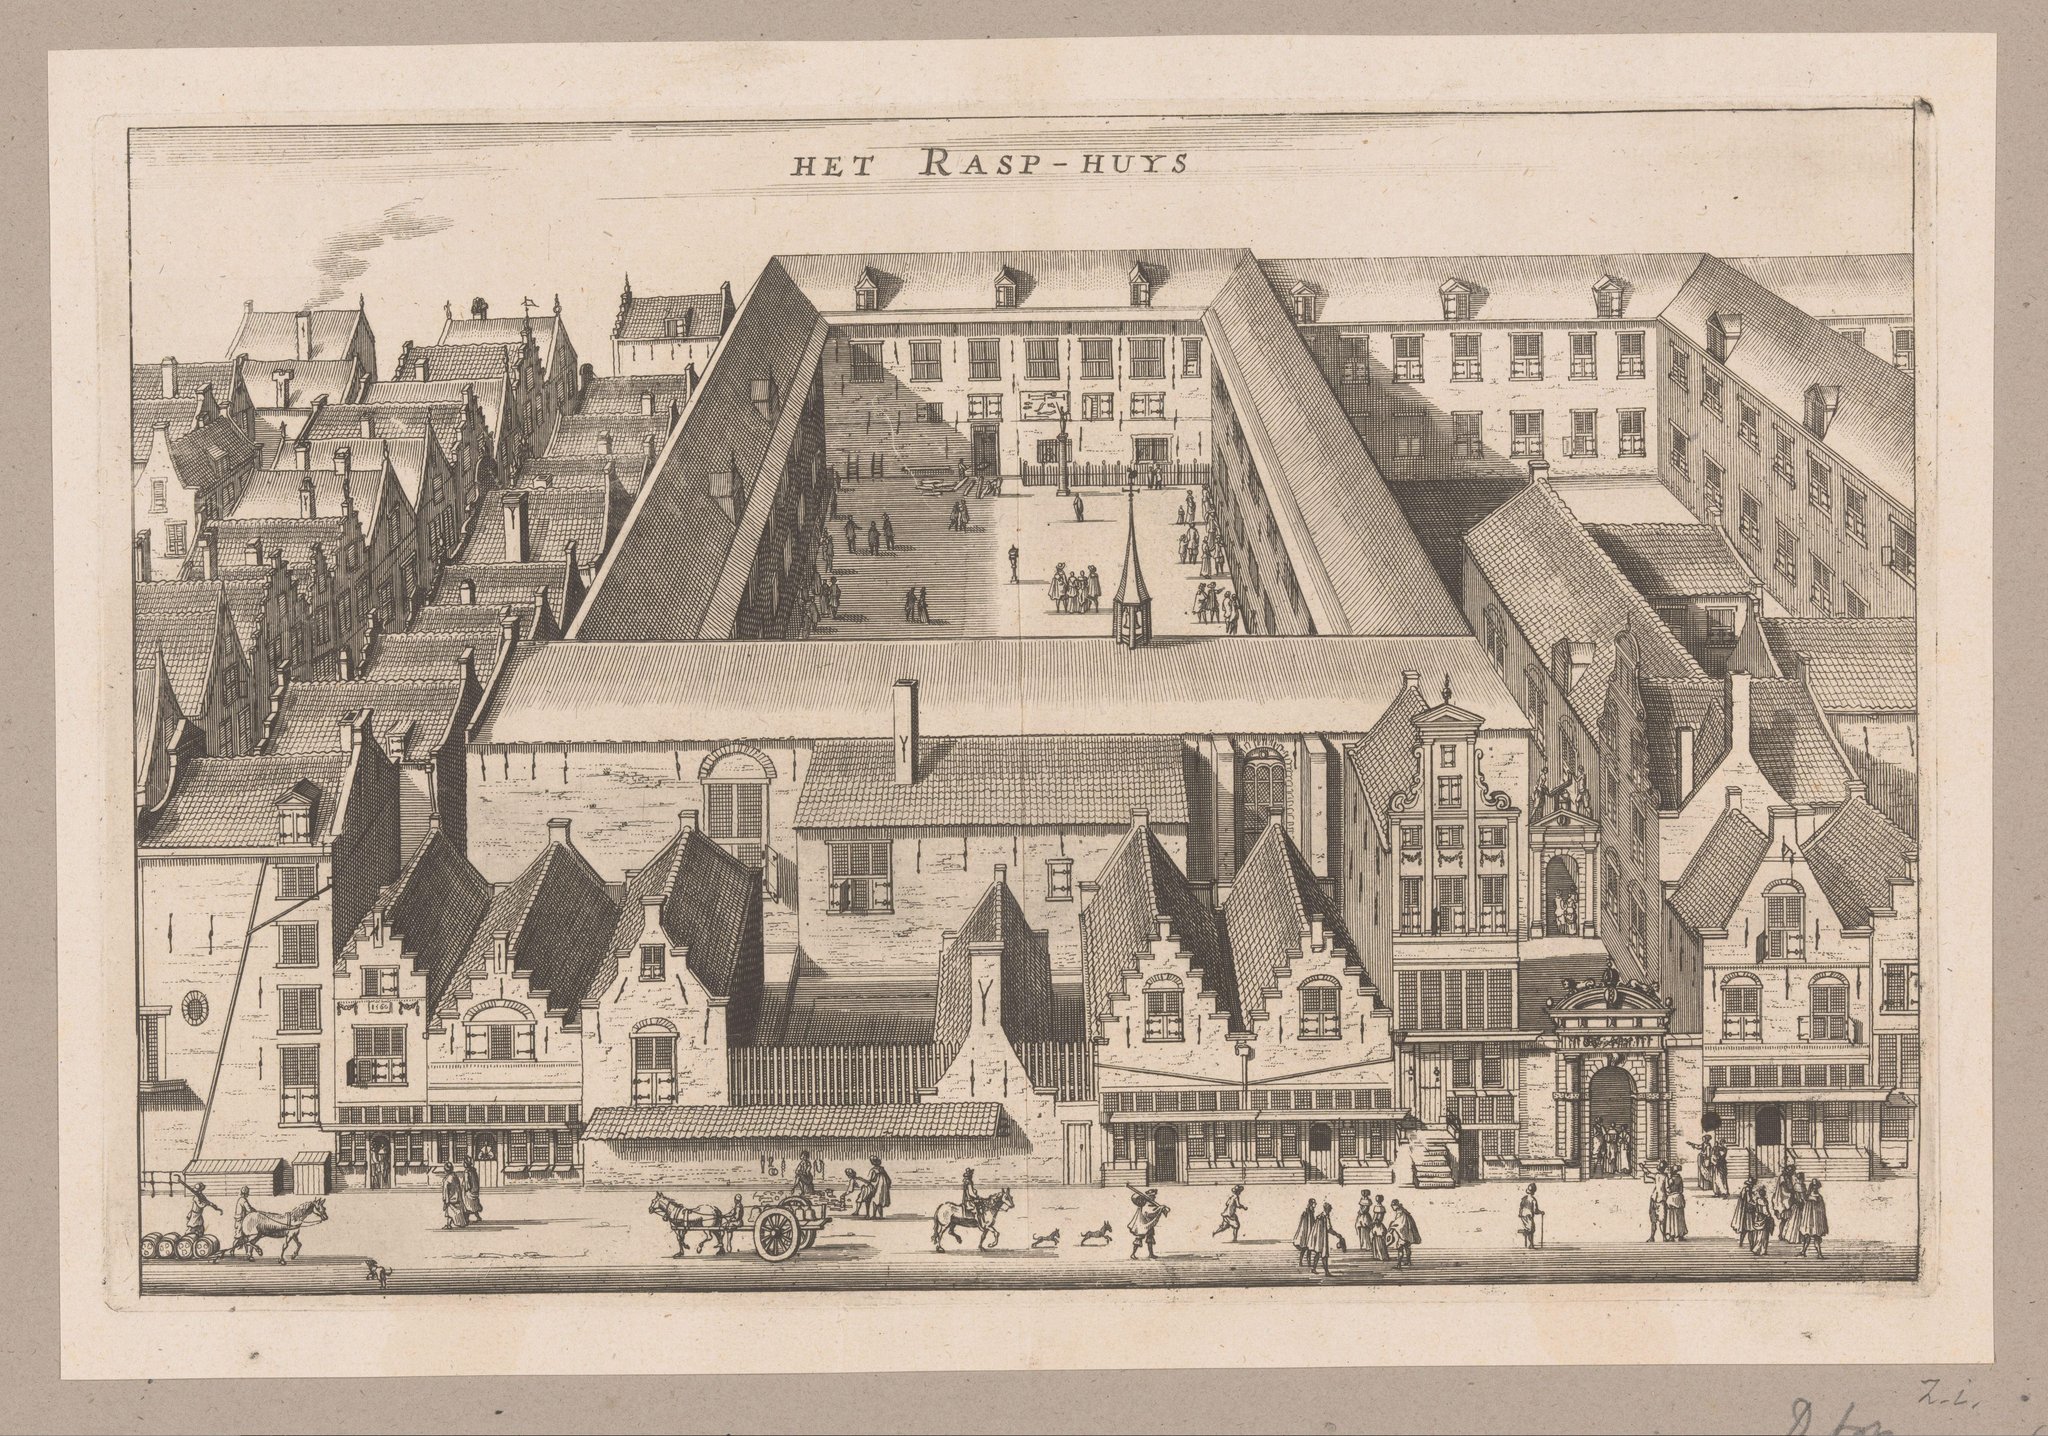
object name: print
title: Het Rasp-Huys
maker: jacob van meurs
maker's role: draughtsman, print maker, publisher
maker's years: 1619-1680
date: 1663-1664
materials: paper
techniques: etching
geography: amsterdam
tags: prison, jail, gate, entrance, courtyard, workhouse, penal camp, penitentiary, chain gang, street (+ city(-scape) with figures, staffage)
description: Prent mogelijk uit: Dapper, Olfert. Historische beschryving der stadt Amsterdam (…). Amsterdam: Jacob van Meurs, 1663. Of uit: Zesen, Philipp von. Beschreibung der Stadt Amsterdam (…). Amsterdam: Joachim Nosche, 1664. Bij sommige exemplaren van eerstgenoemde uitgave werd een latere staat ingebonden waarop boven de Nederlandse titel ook een Franse is toegevoegd.